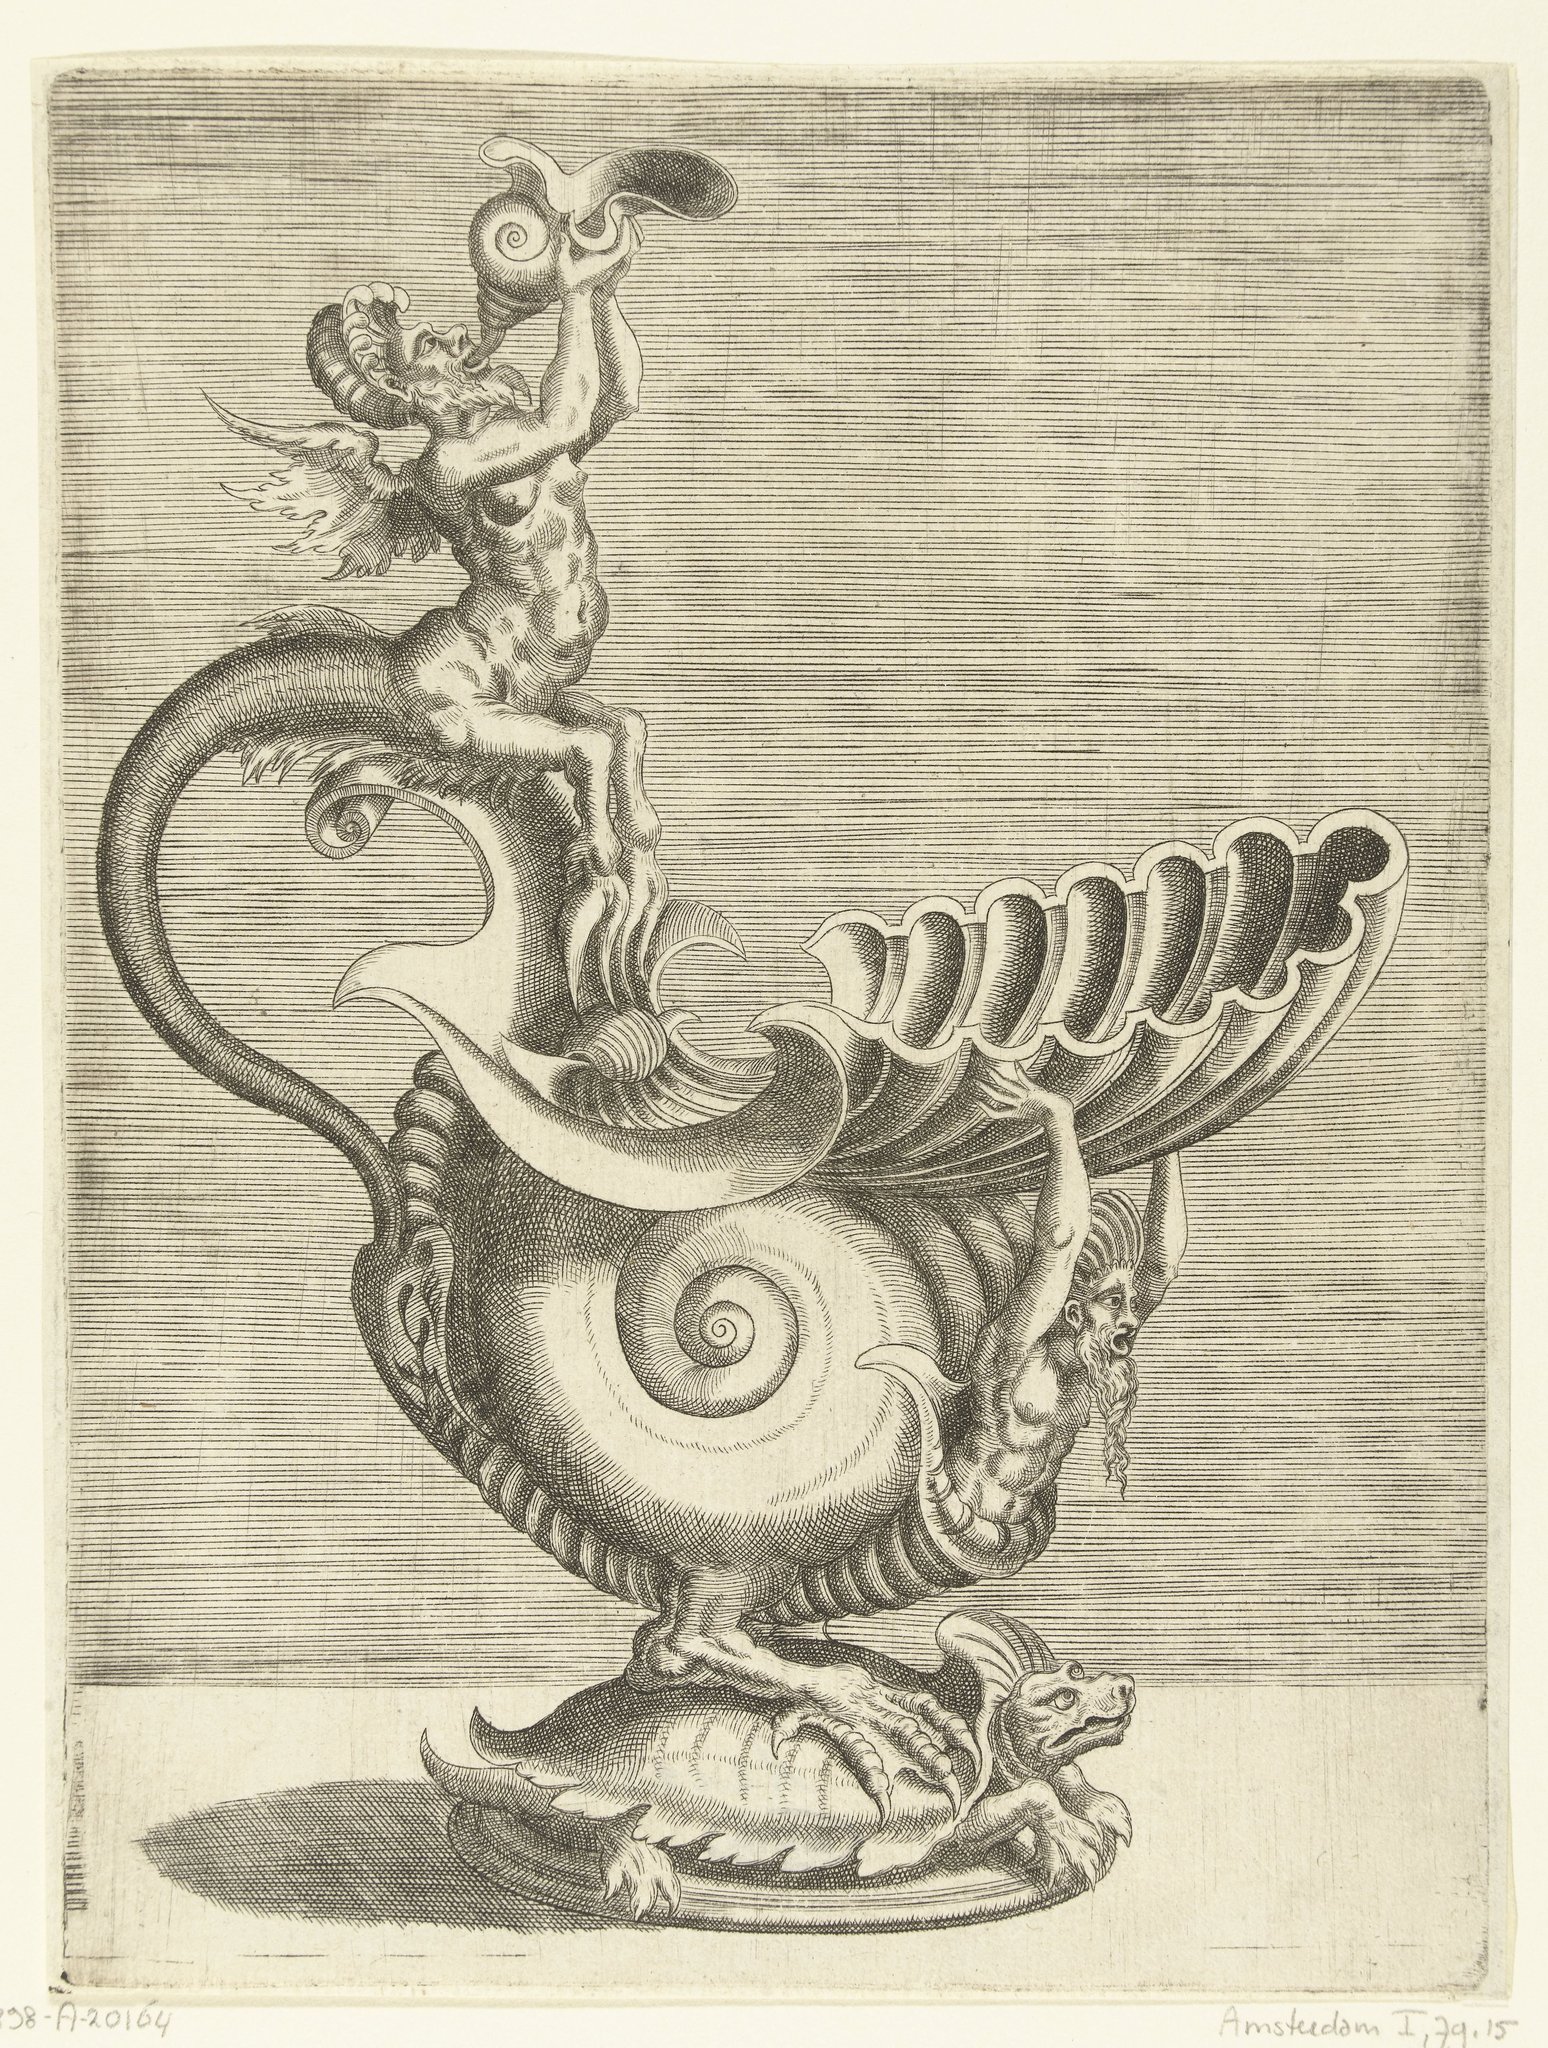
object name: ornament print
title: Verschillende bekers en drinkschalen. Suite van 20 stuks (de titel ontbreekt)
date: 1548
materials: paper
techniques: engraving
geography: netherlands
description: De voet van de kan is een klauw die op een schildpad staat. Op het oor zit een gevleugelde sater die op een schelp blaast. Afkomstig uit een serie bestaande uit een titelblad en 20 bladen.